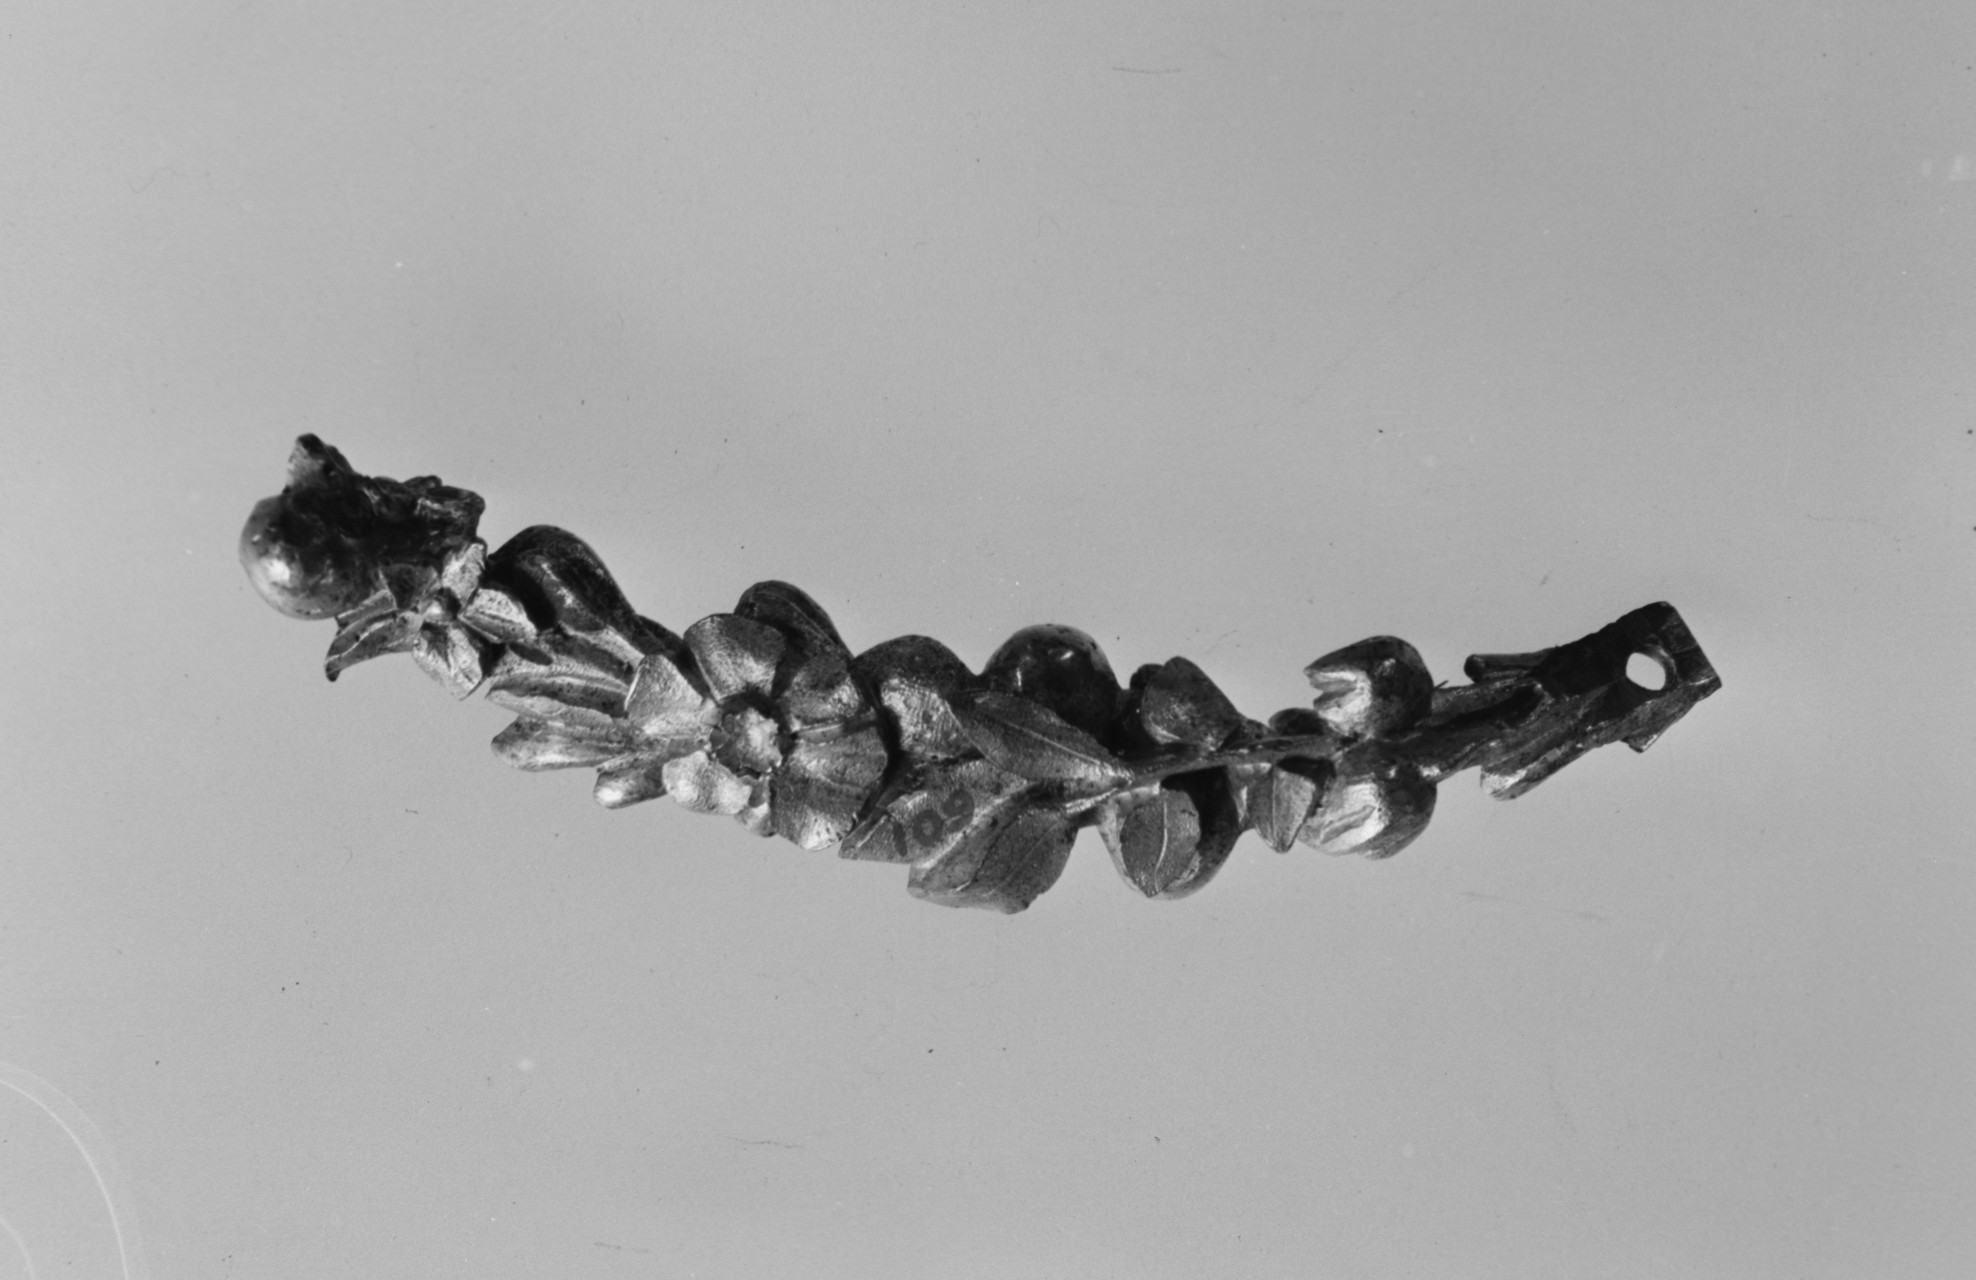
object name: chute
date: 1701-1800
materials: gilt bronze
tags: flowers,leaves